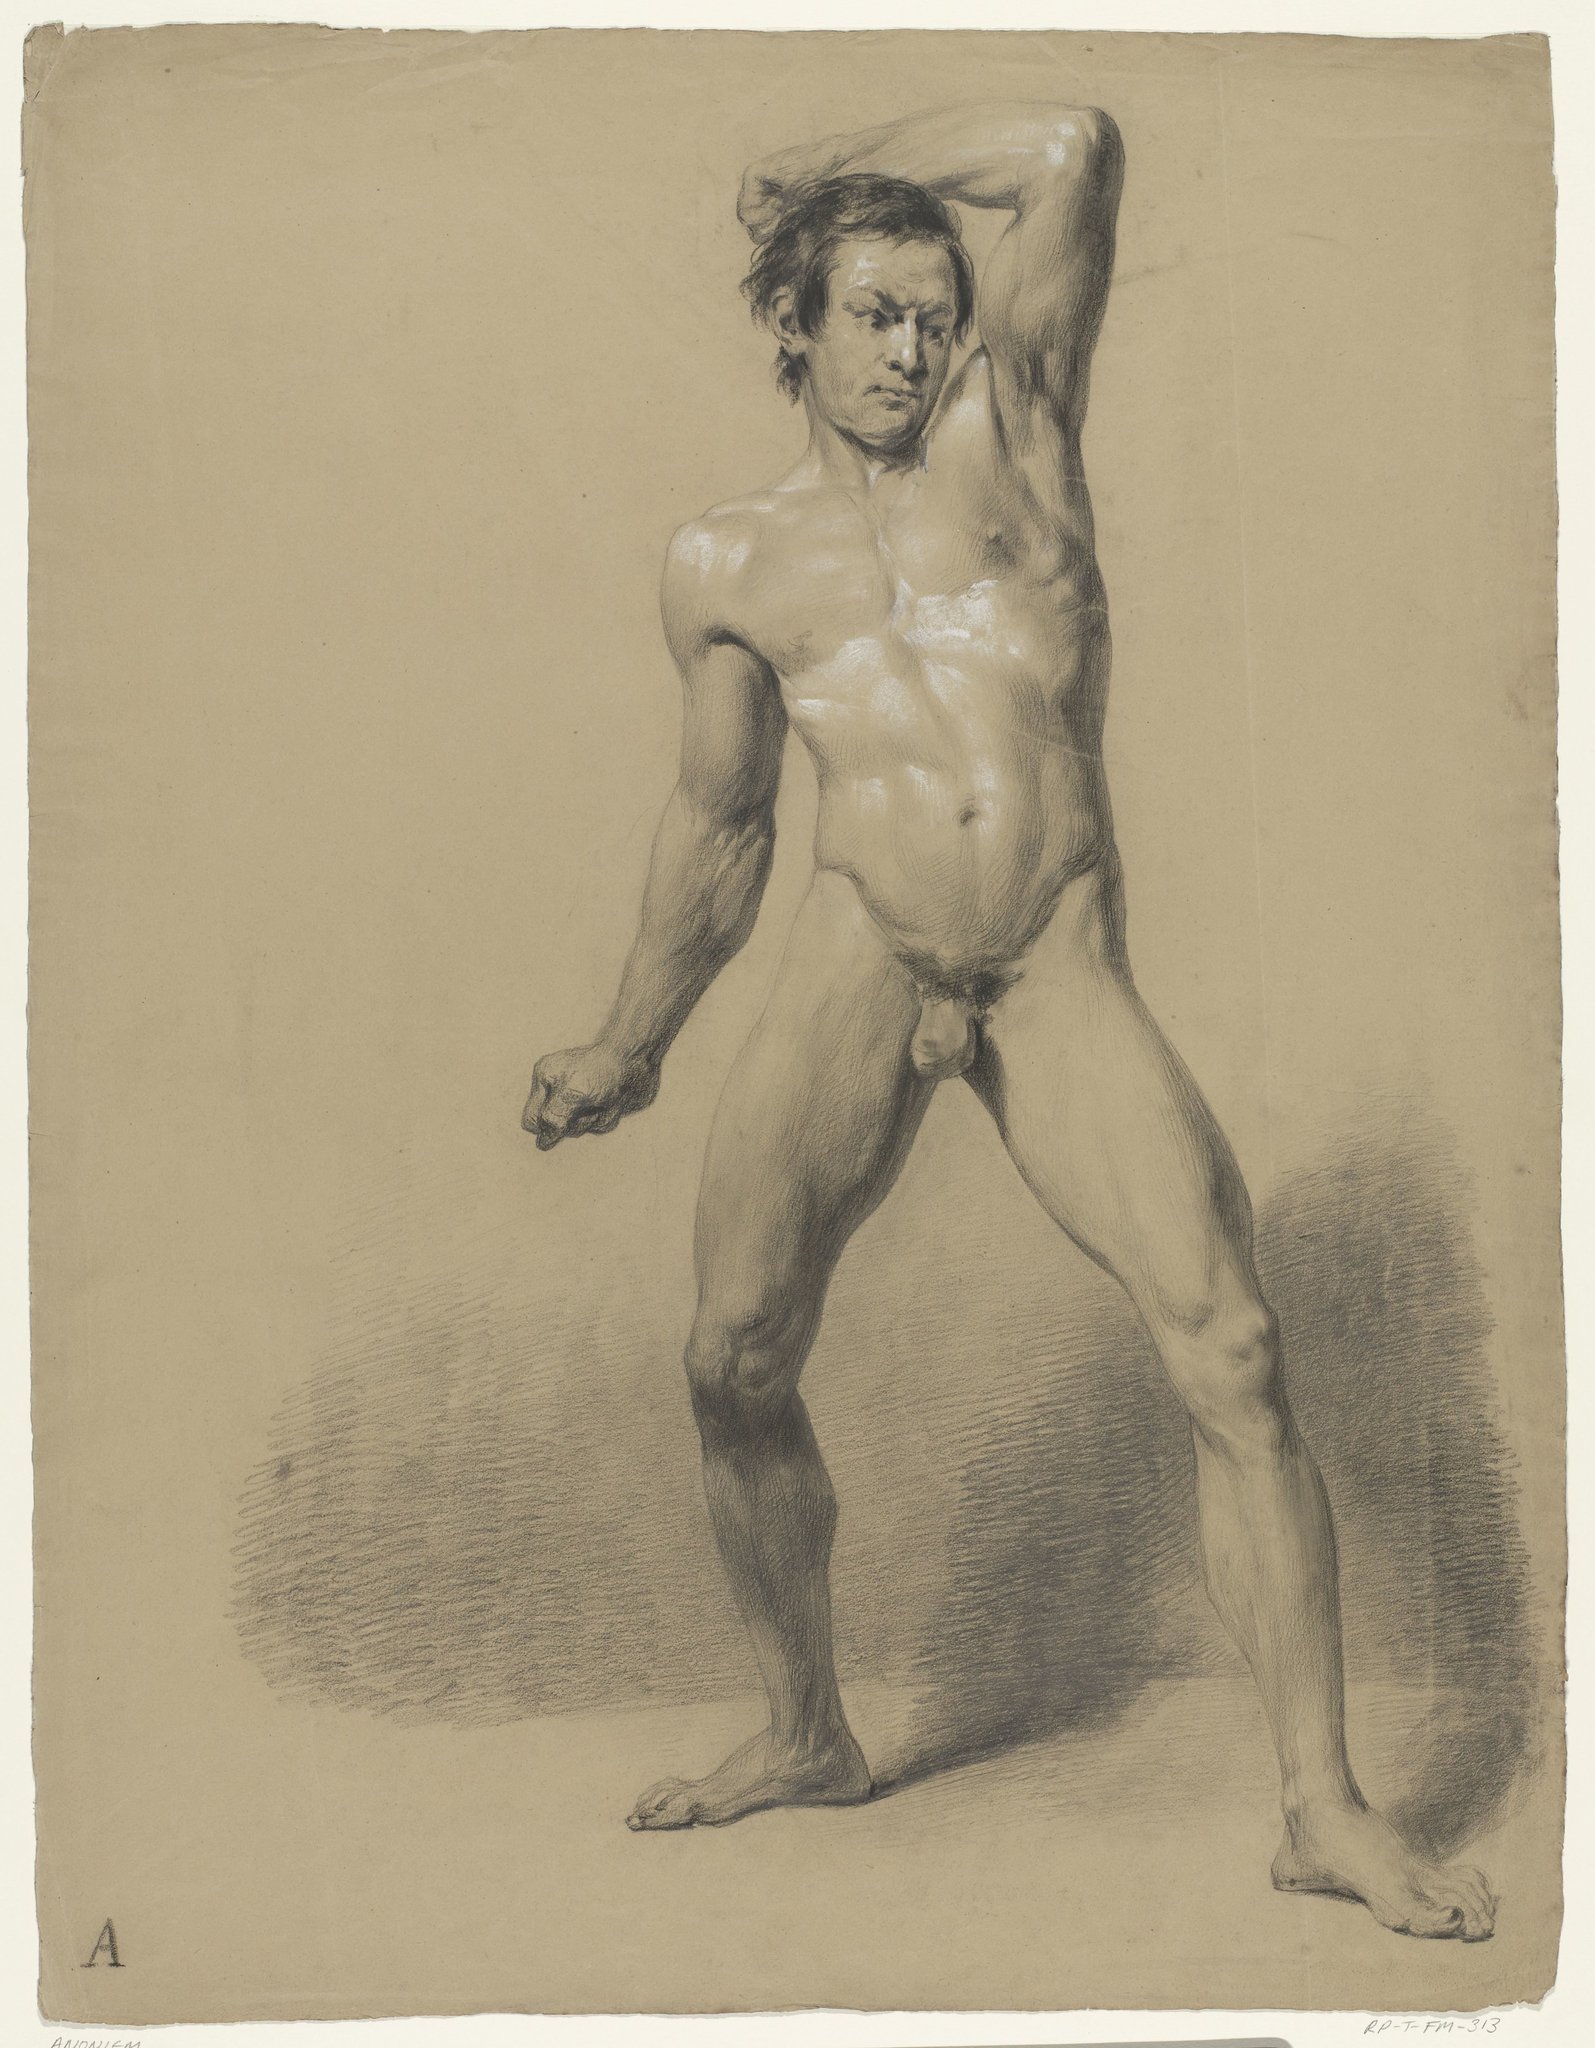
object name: drawing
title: Staand mannelijk naakt met gebalde vuisten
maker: Anonymous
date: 1842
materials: chalk, paper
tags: standing figure